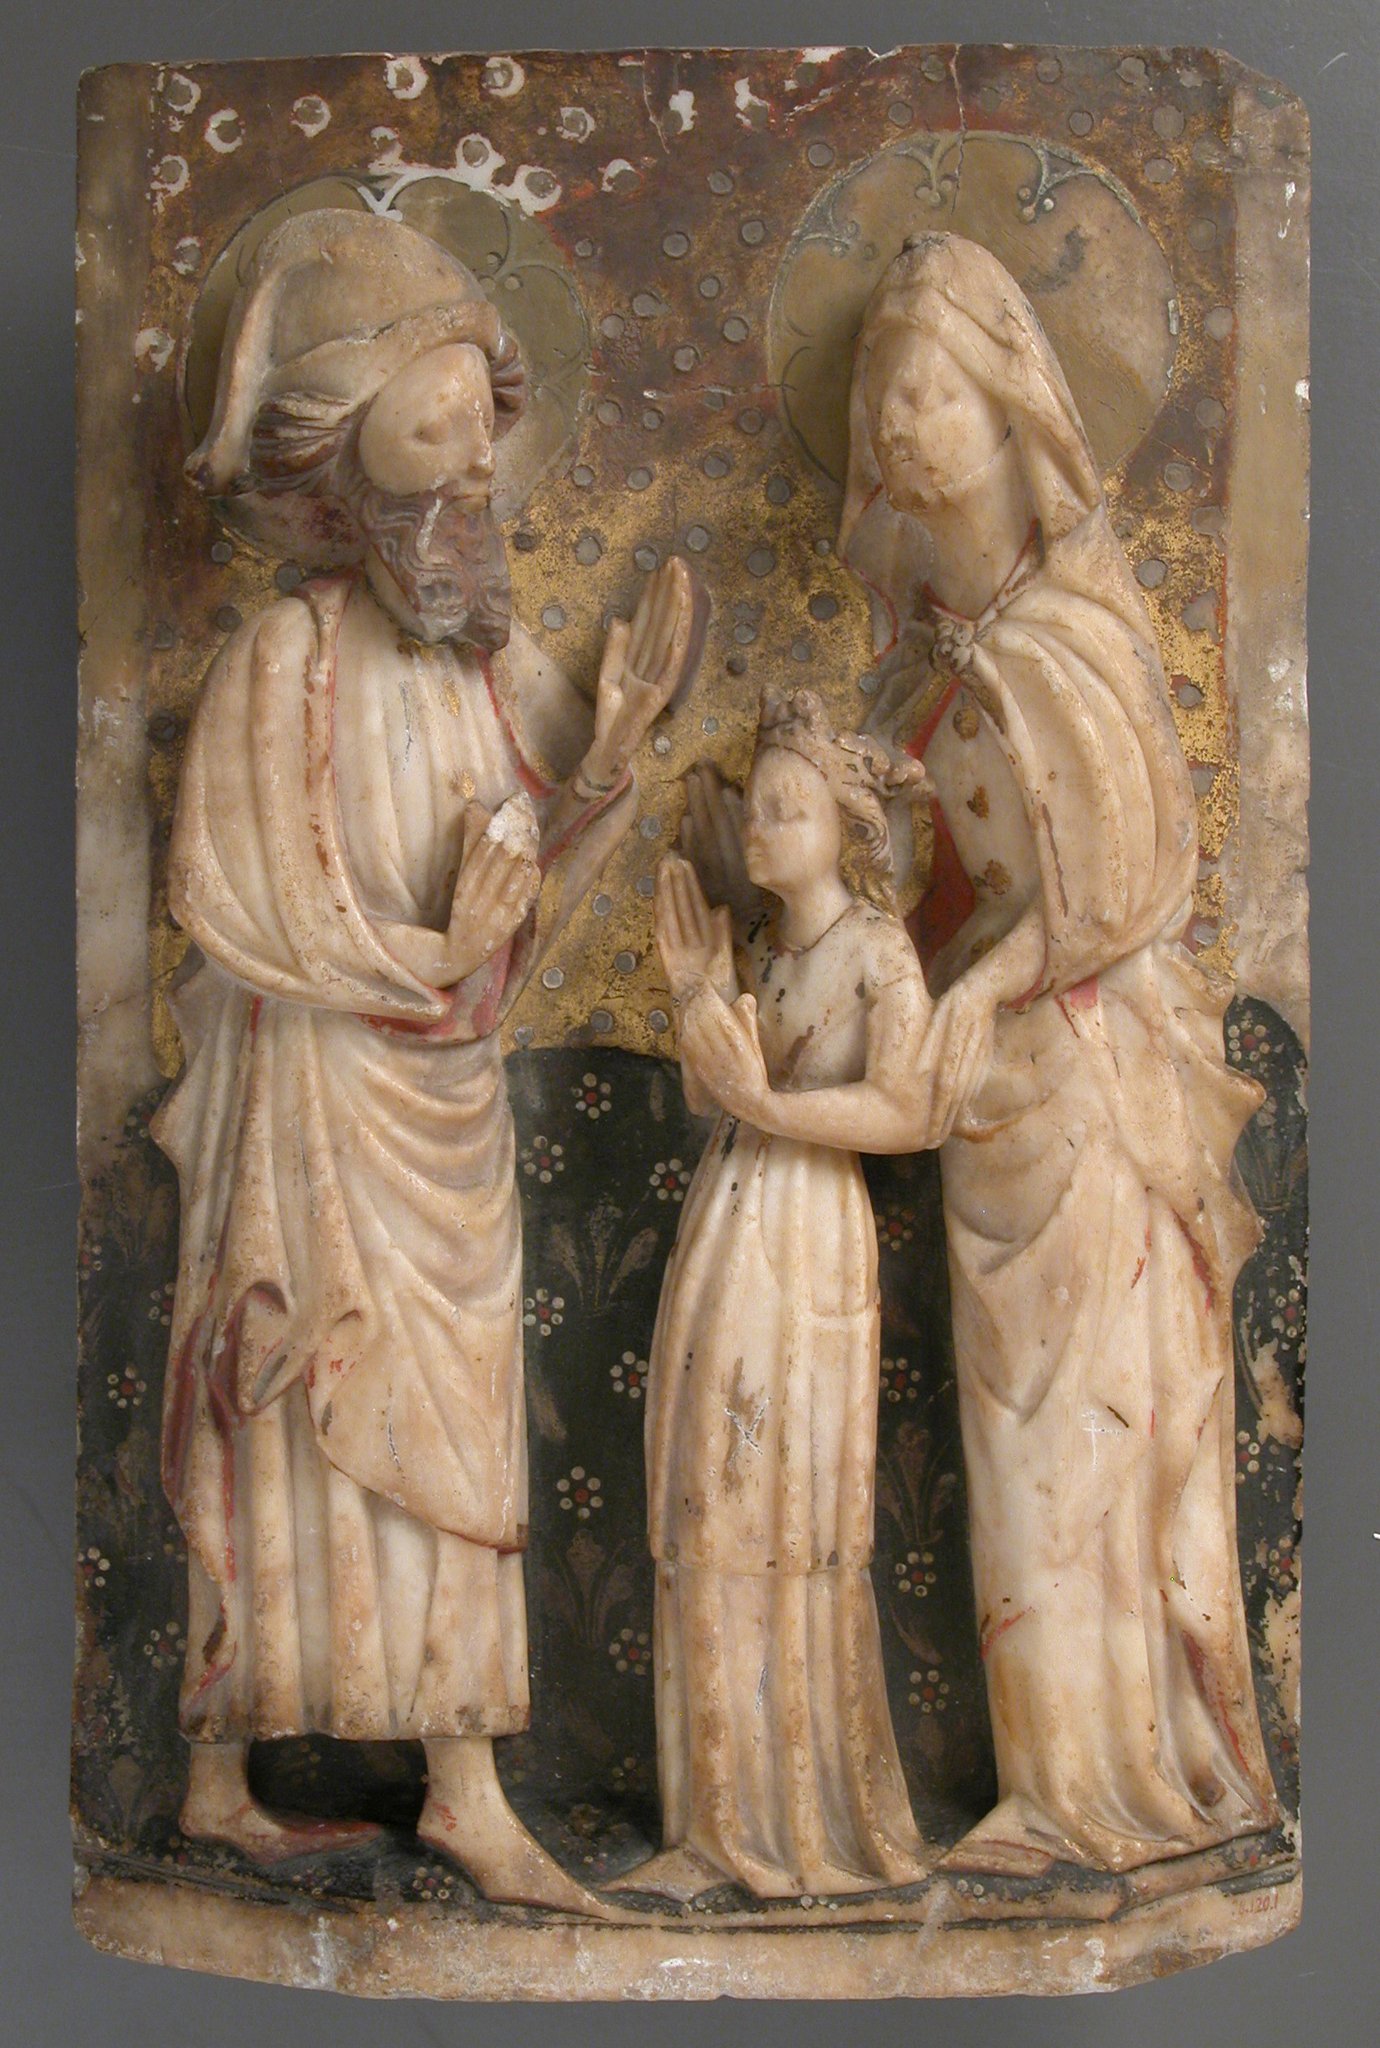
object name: relief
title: Virgin, Saint Anne & Saint Joachim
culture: british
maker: school of nottingham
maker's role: artist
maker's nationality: british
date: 1401-1500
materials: alabaster, paint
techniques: gilding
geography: england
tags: saint anne